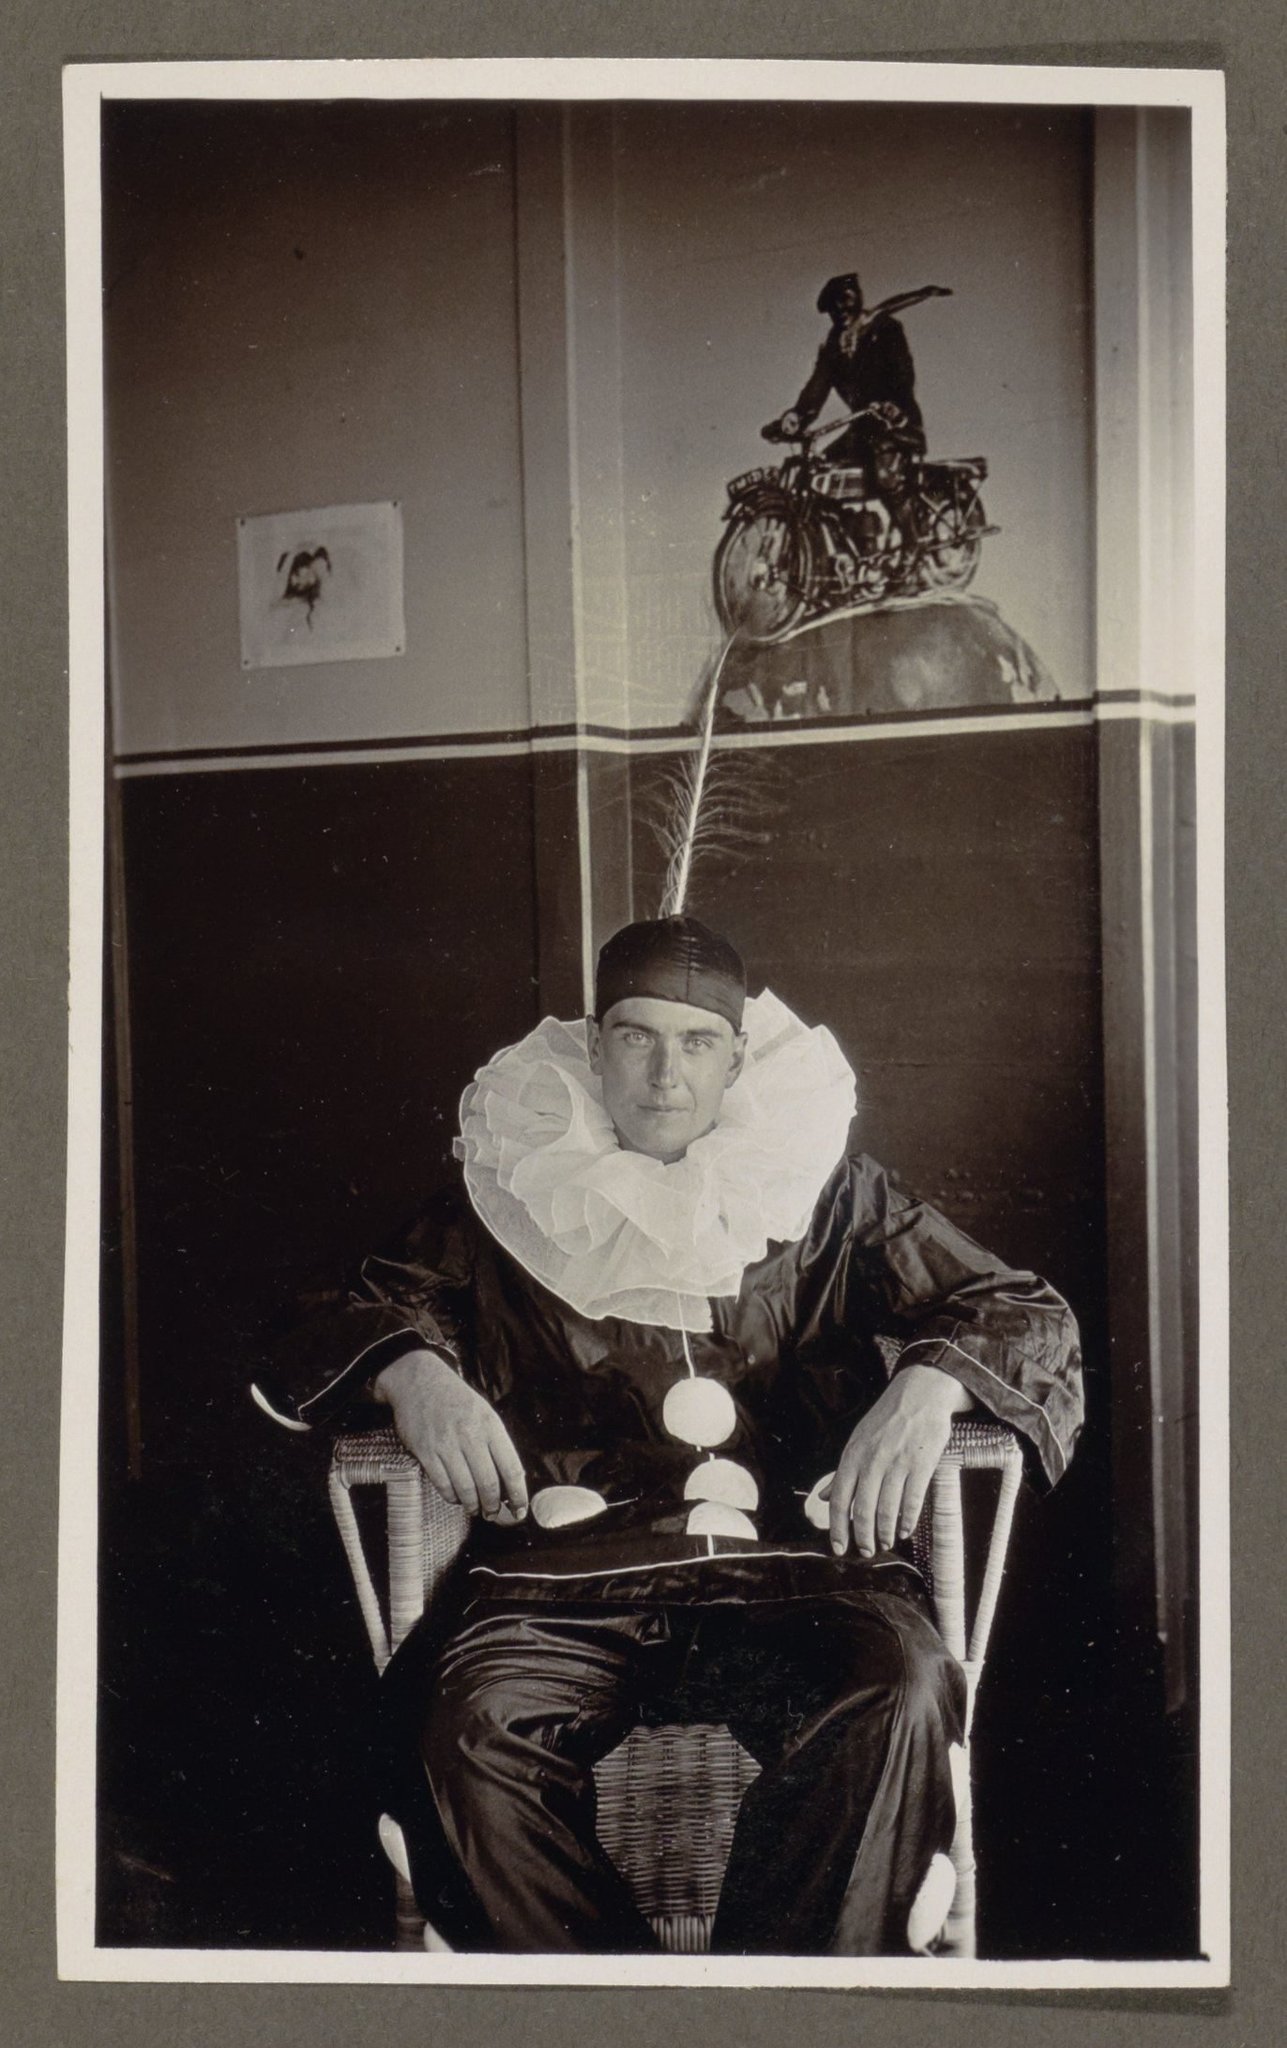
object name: photograph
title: Man verkleed als pierrot, zittend in een rieten stoel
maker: Anonymous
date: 1920-1930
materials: photographic support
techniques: gelatin silver print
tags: types in 'commedia dell'arte': pierrot, dutch east indies, the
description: Onderdeel van familiealbum Nederlands-Indië.